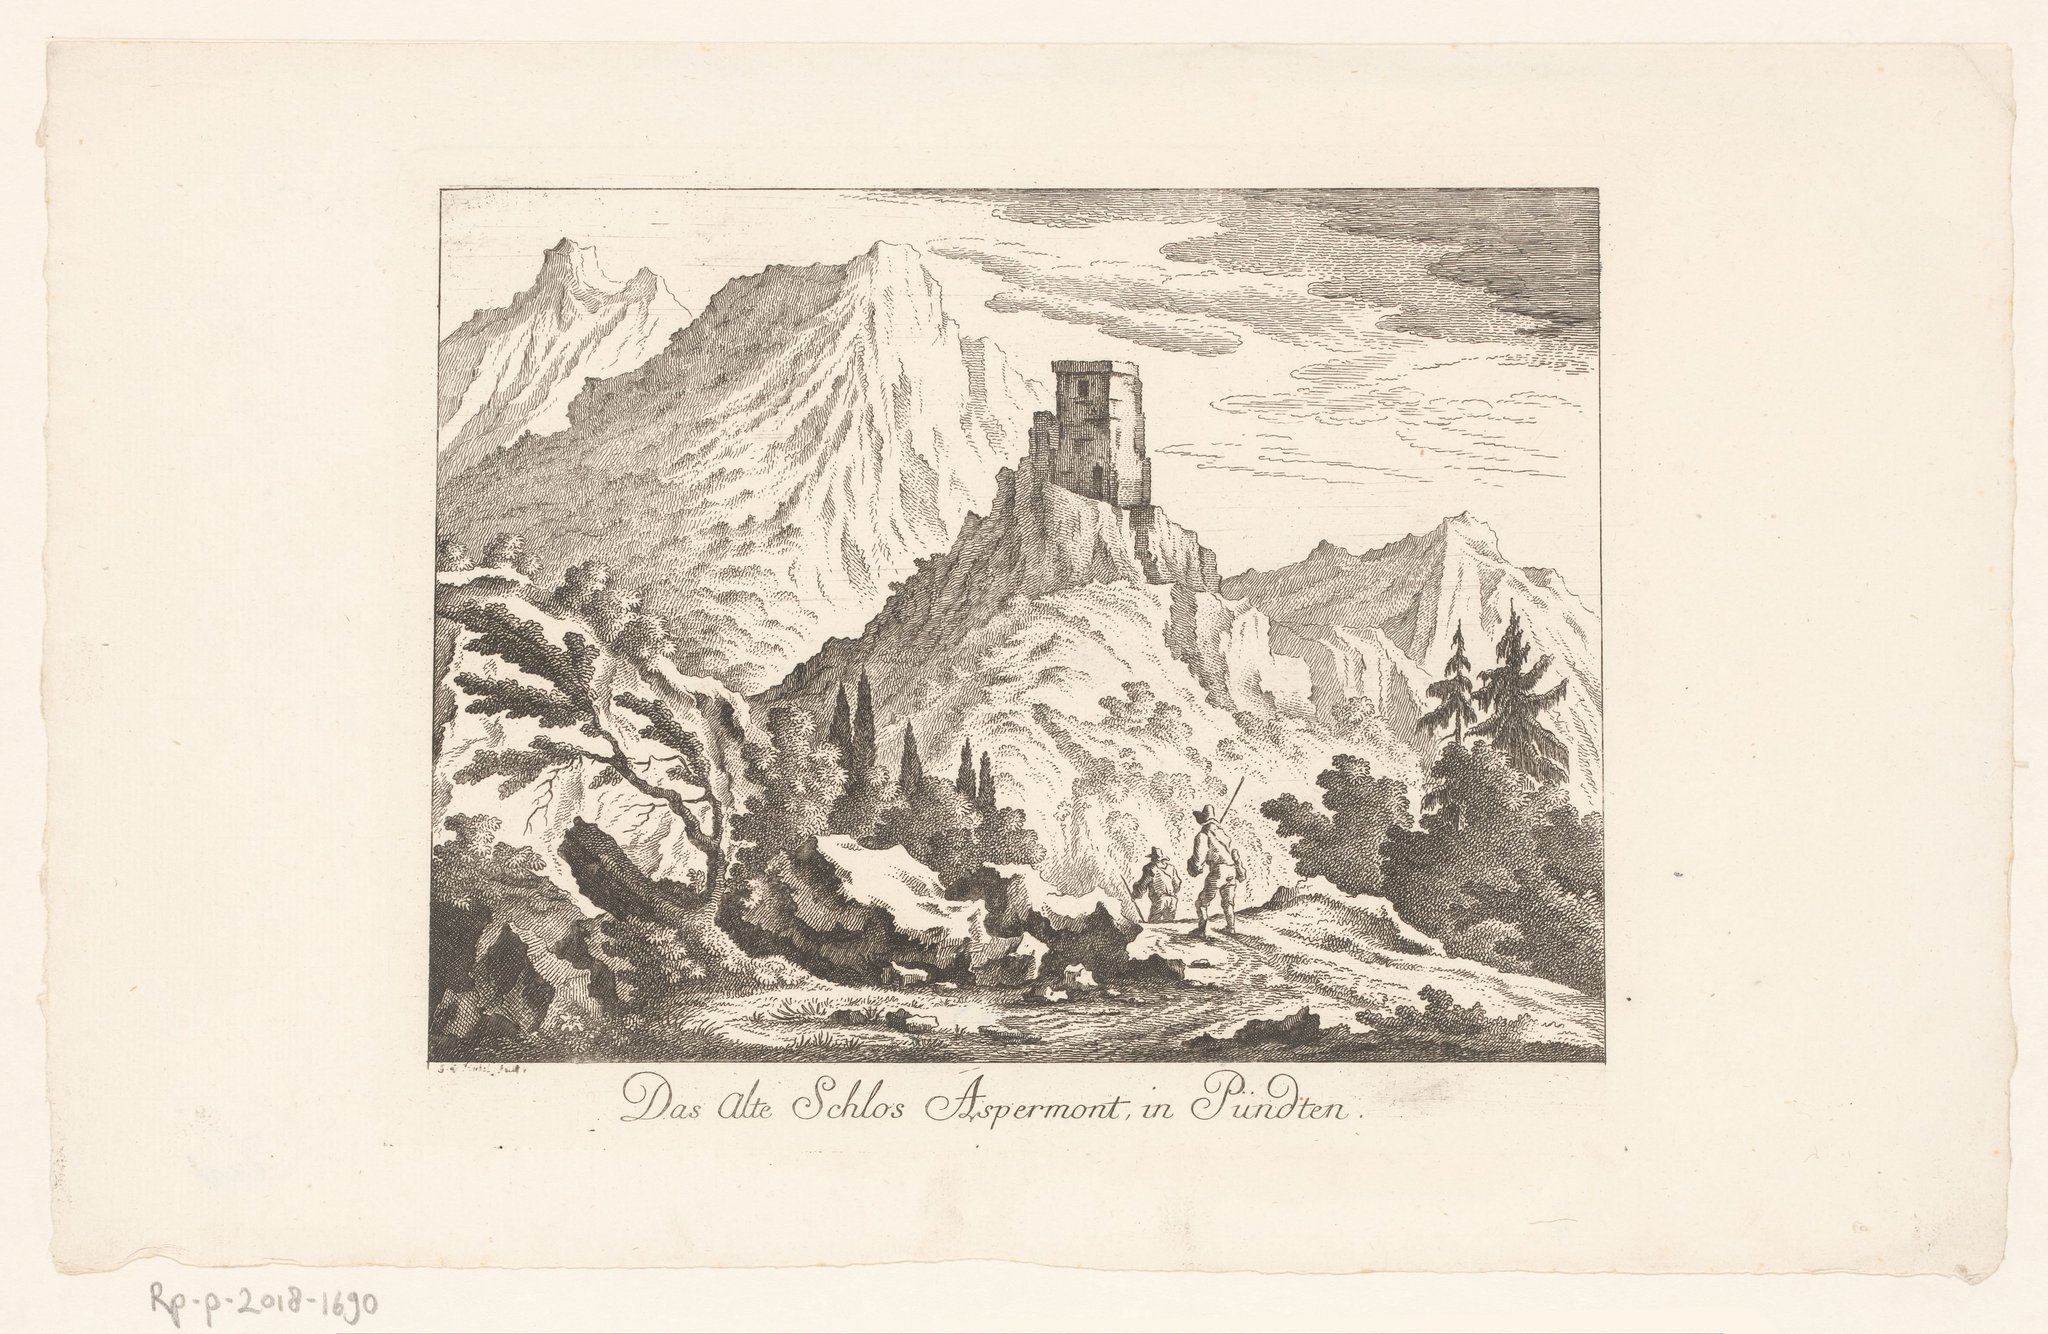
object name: print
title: Gezicht op de ruïne van kasteel Aspermont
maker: Anonymous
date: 1650-1749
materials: paper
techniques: etching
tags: castle, ruin of a dwelling, house, castle, etc.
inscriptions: collector's mark: Lugt 2228